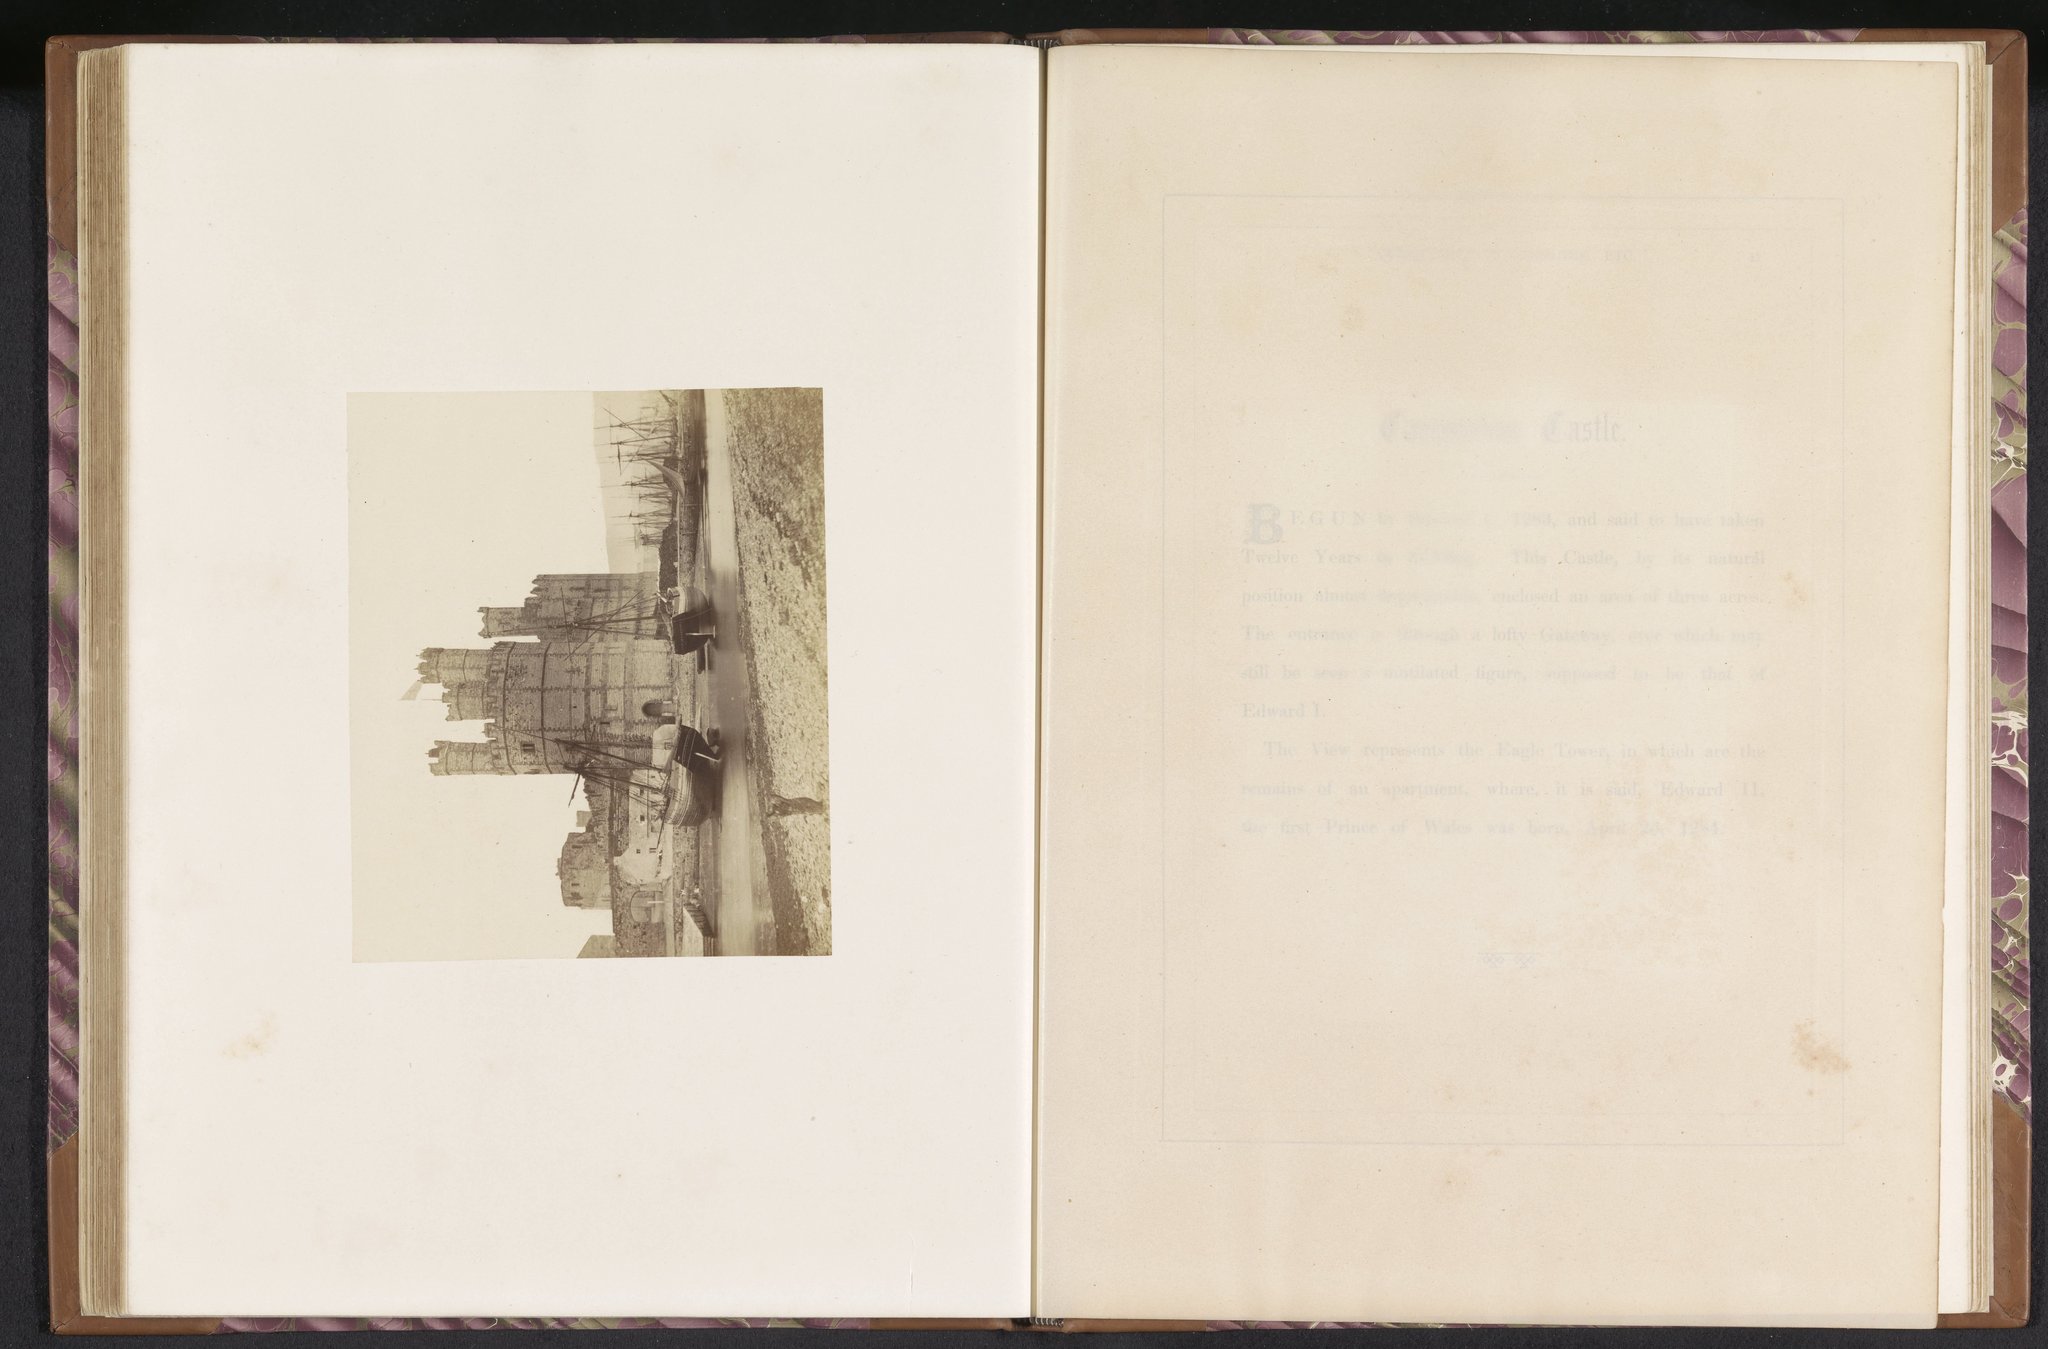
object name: photograph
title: Caernavon Castle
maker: william bryans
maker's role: fotograaf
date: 1850-1858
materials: photographic support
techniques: albumen print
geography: caernafon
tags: castle, tower (of house or building)